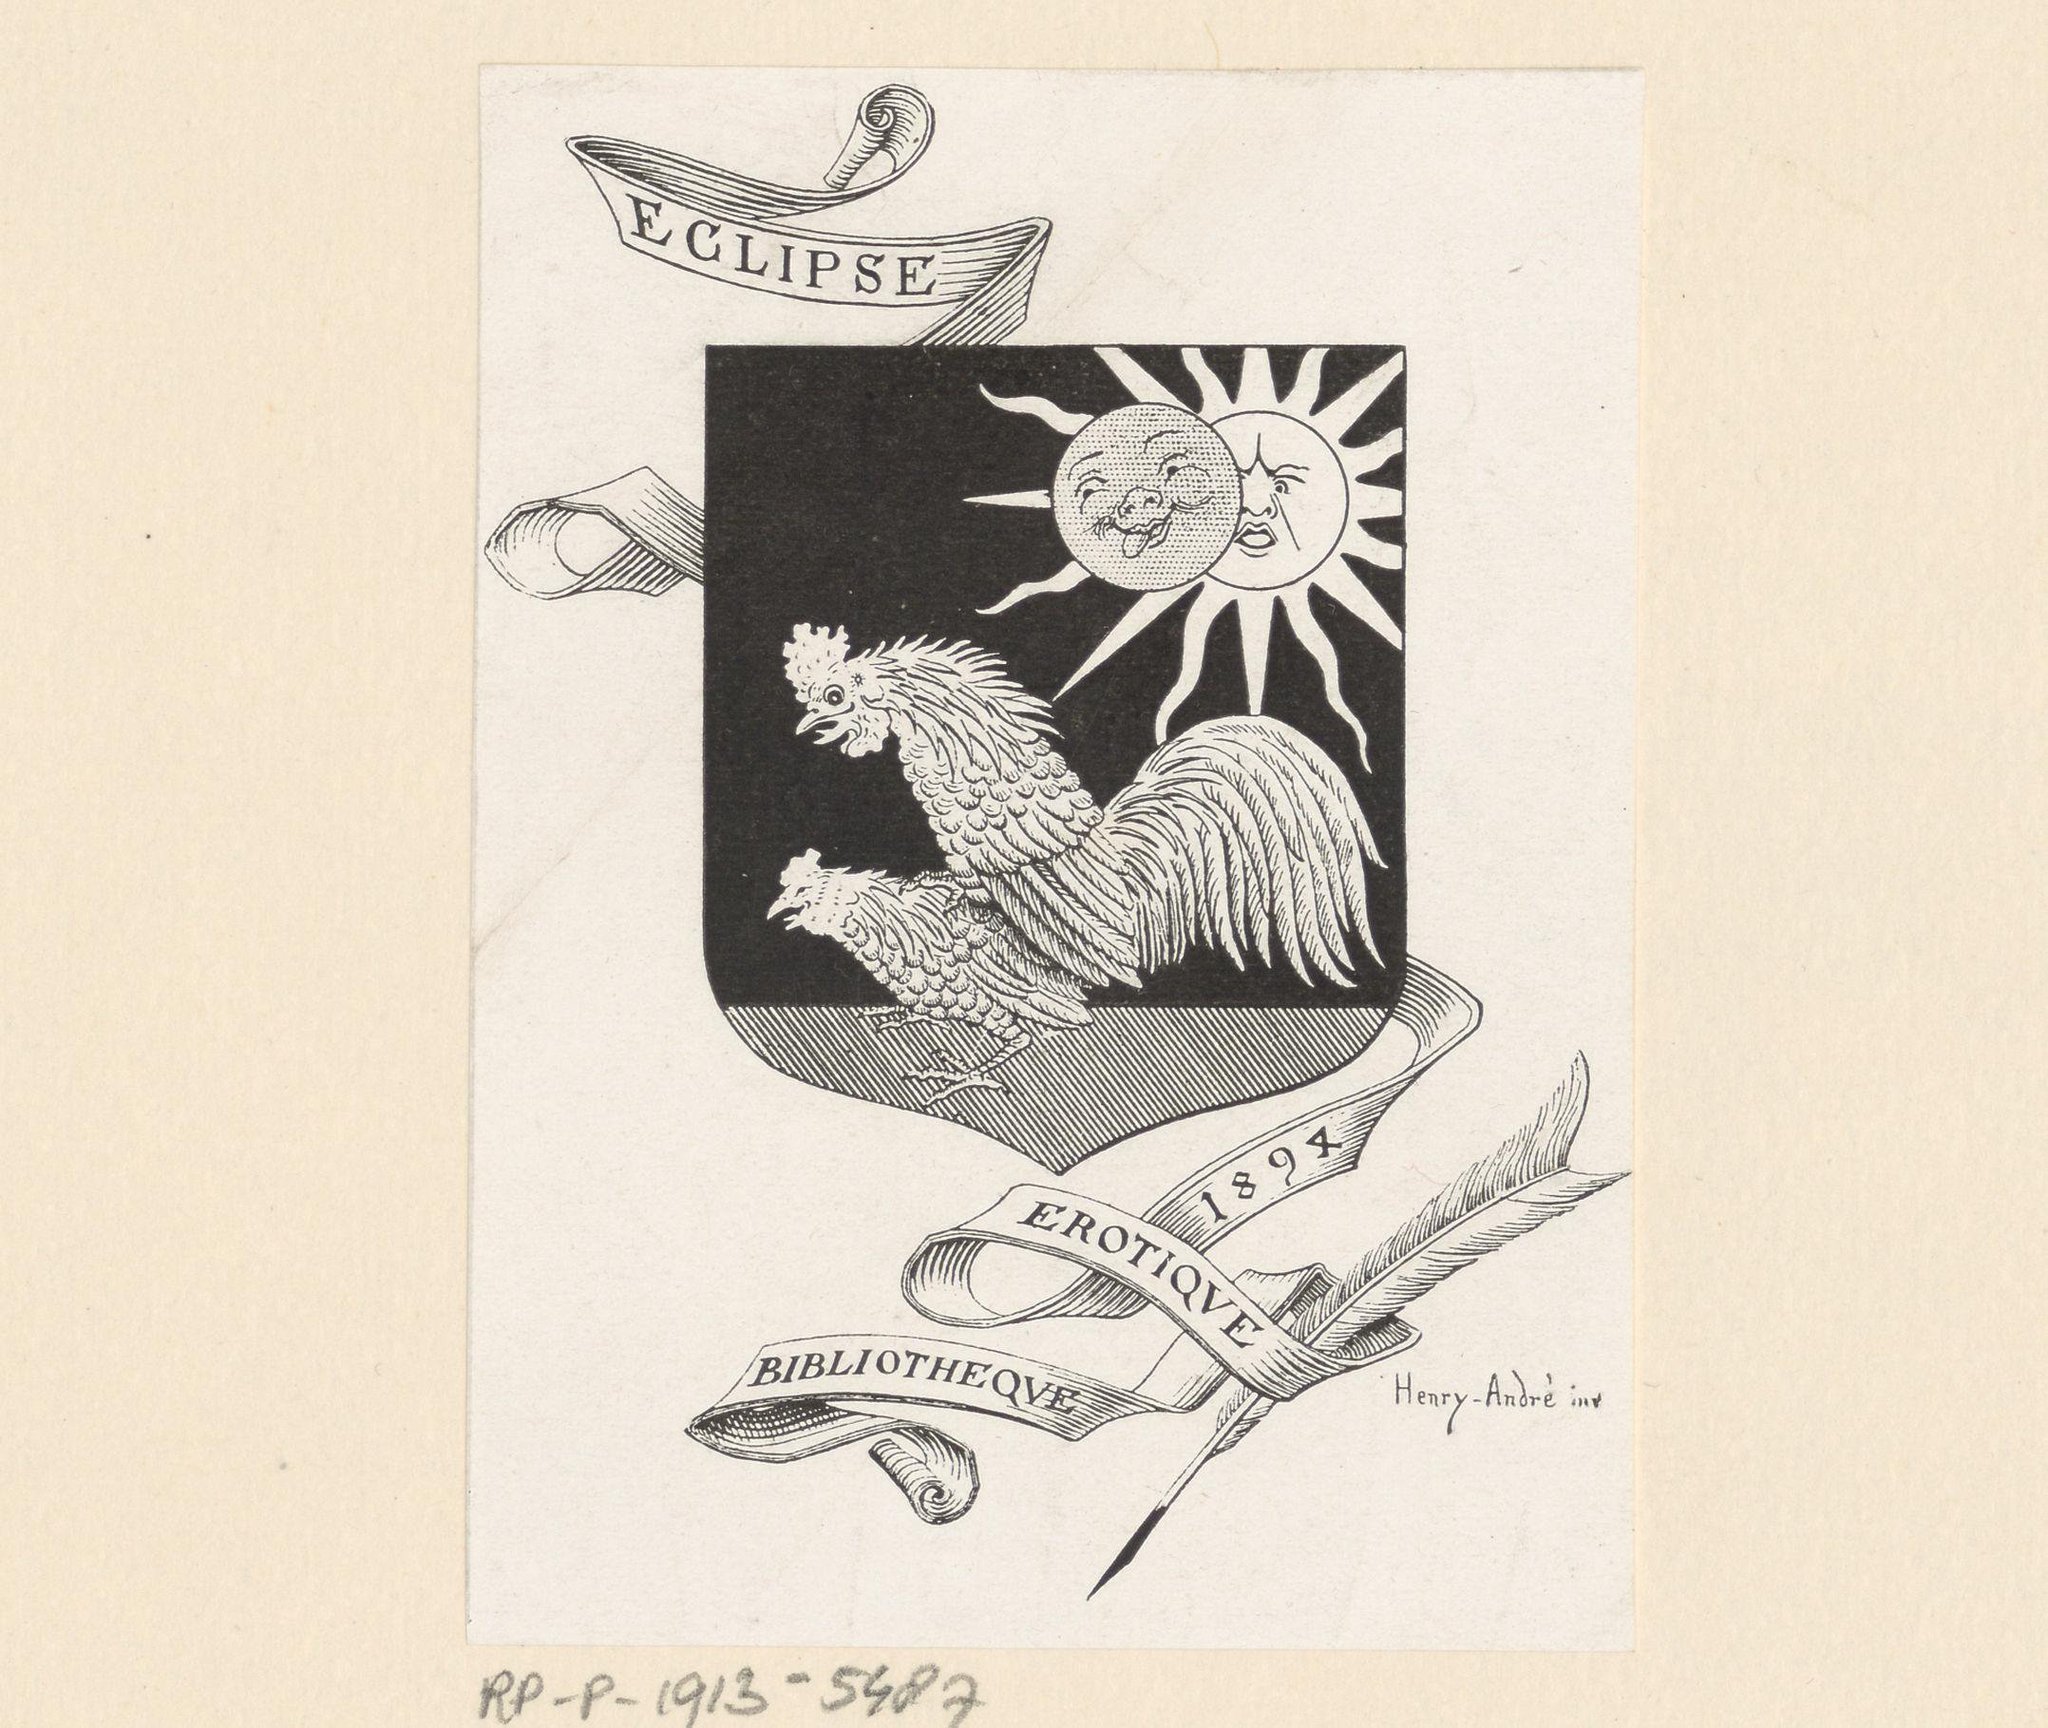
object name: bookplate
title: Eclipse bibliotheque erotique 1894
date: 1894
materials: paper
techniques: printing block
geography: france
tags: quill, fowl (cock, hen, chicken, etc.), solar eclipse, coitus, cohabiting, sexual intercourse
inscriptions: collector's mark: Lugt 2233, collector's mark: Lugt 2760